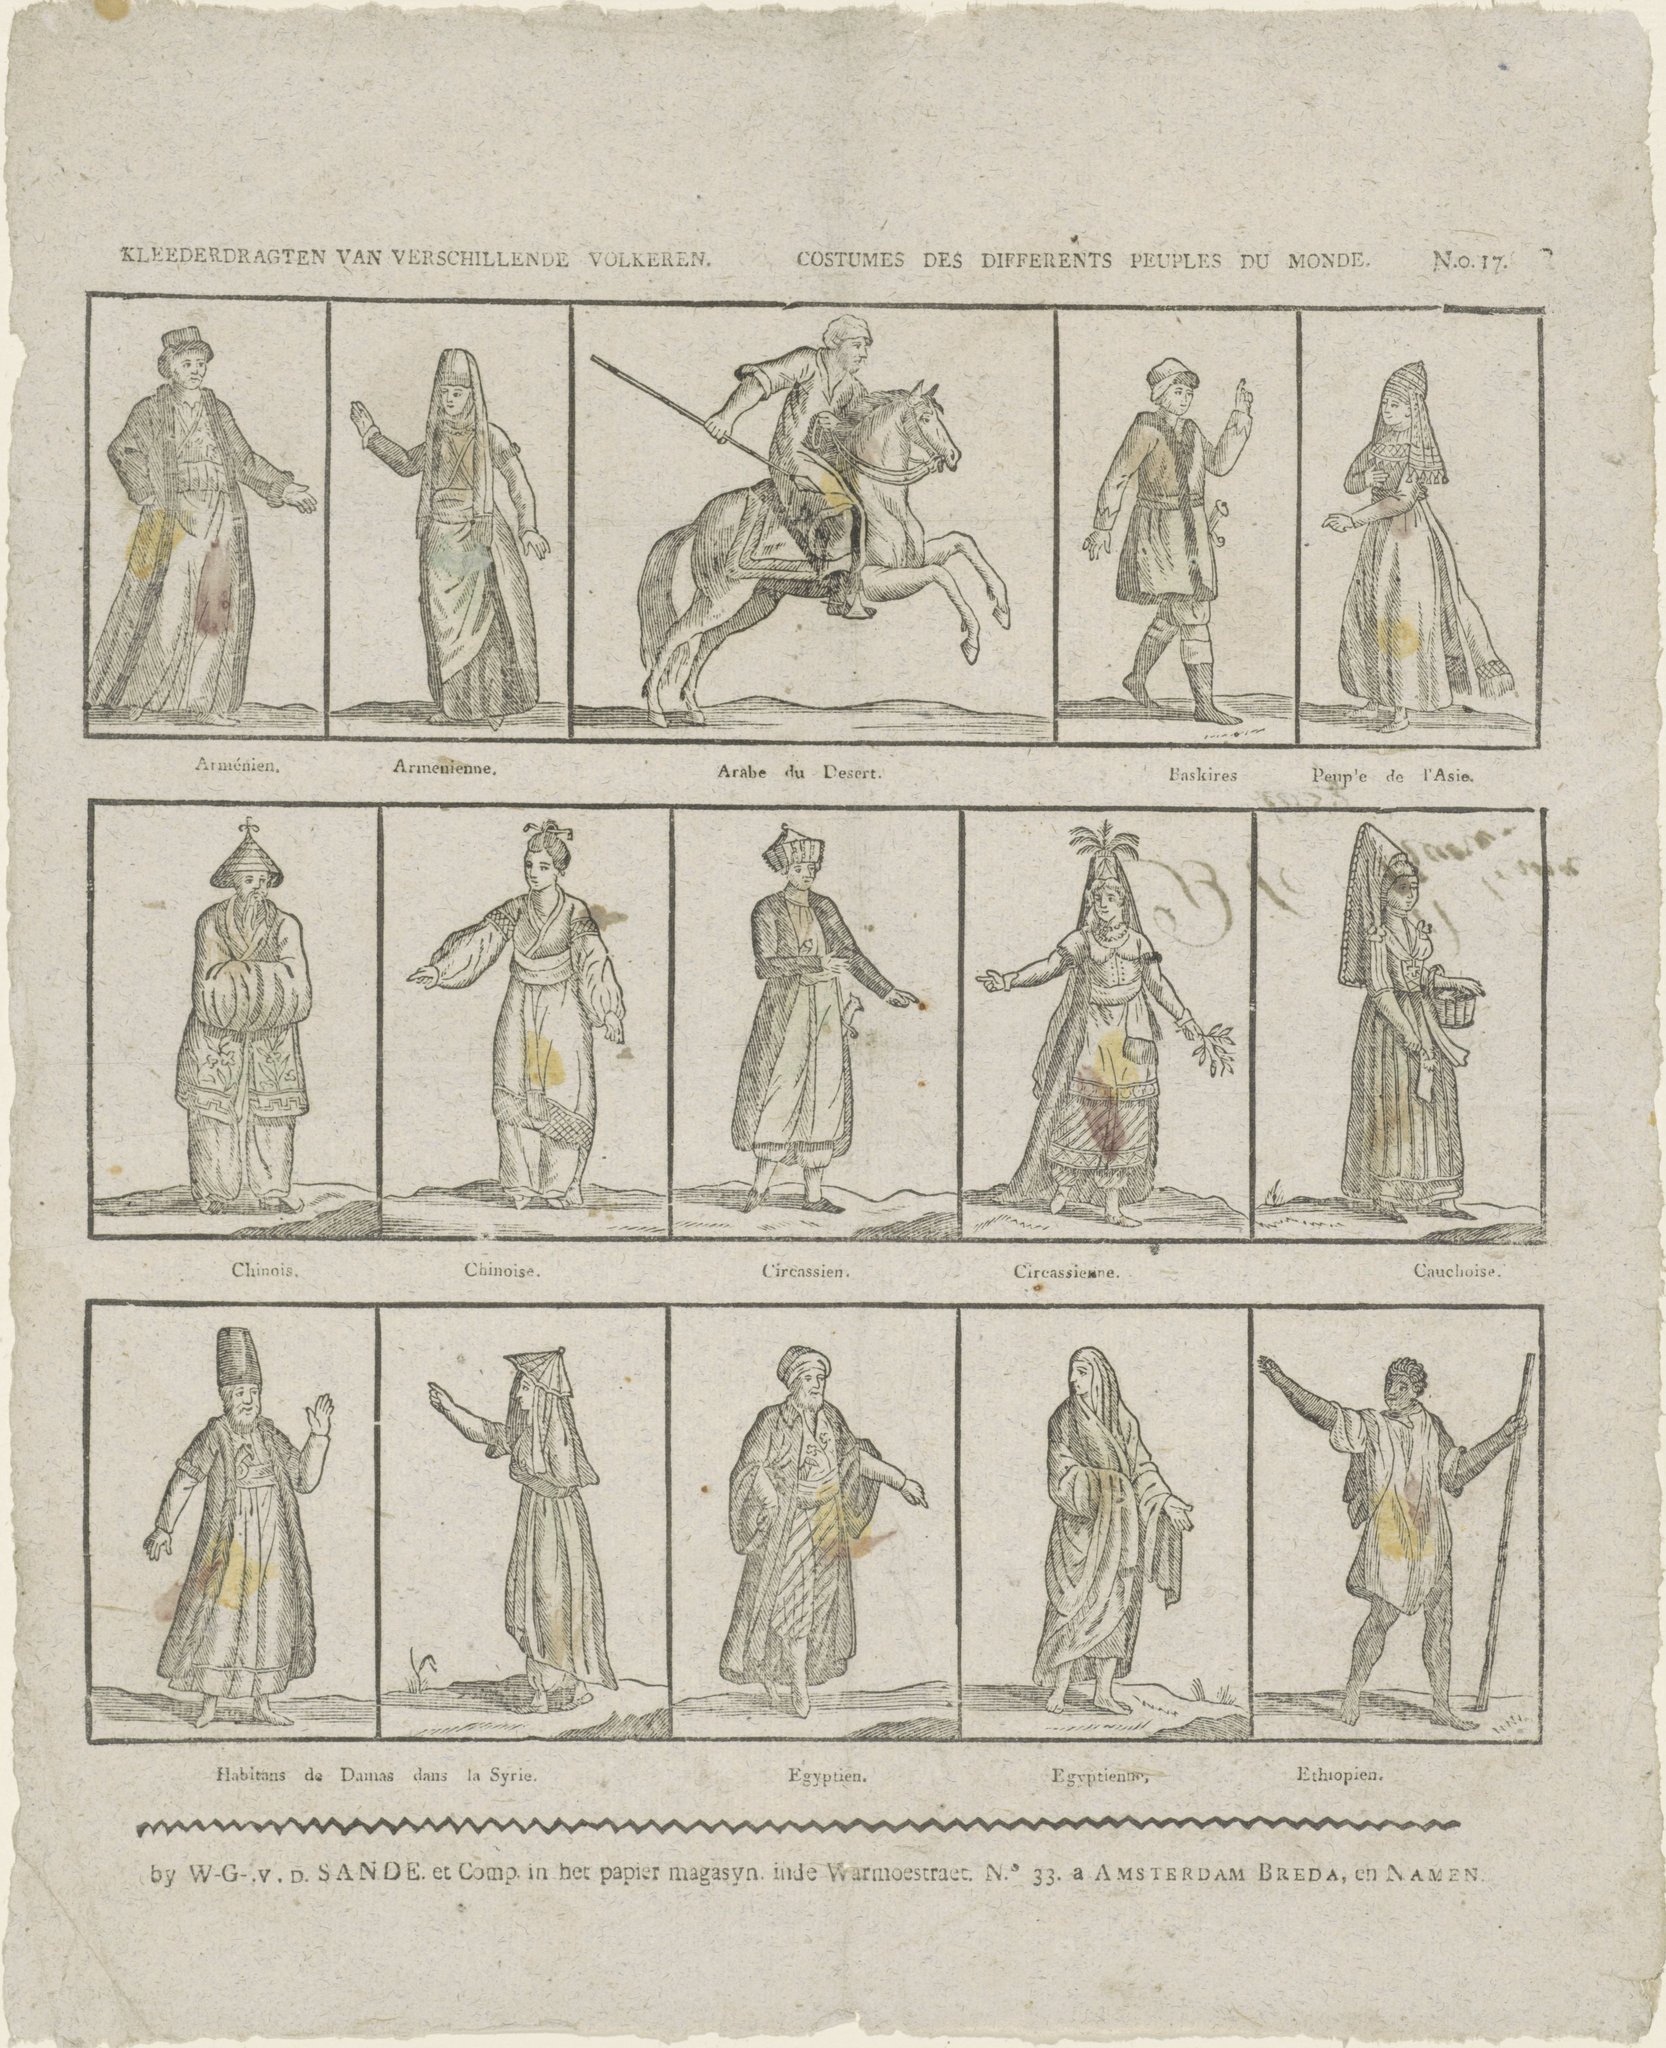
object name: print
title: Kleederdragten van verschillende volkeren / Costumes des differents peuples du monde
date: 1806-1814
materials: paper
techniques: colour, letterpress printing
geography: europe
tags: asiatic races and peoples, africans, historical costume, folk costume, regional costume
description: Blad met 3 houtsneden met elk vijf voorstellingen van klederdrachten van verschillende volkeren, waaronder klederdracht uit China en Egypte. Onder elke voorstelling een onderschrift in het Frans. Genummerd rechtsboven: No. 17.